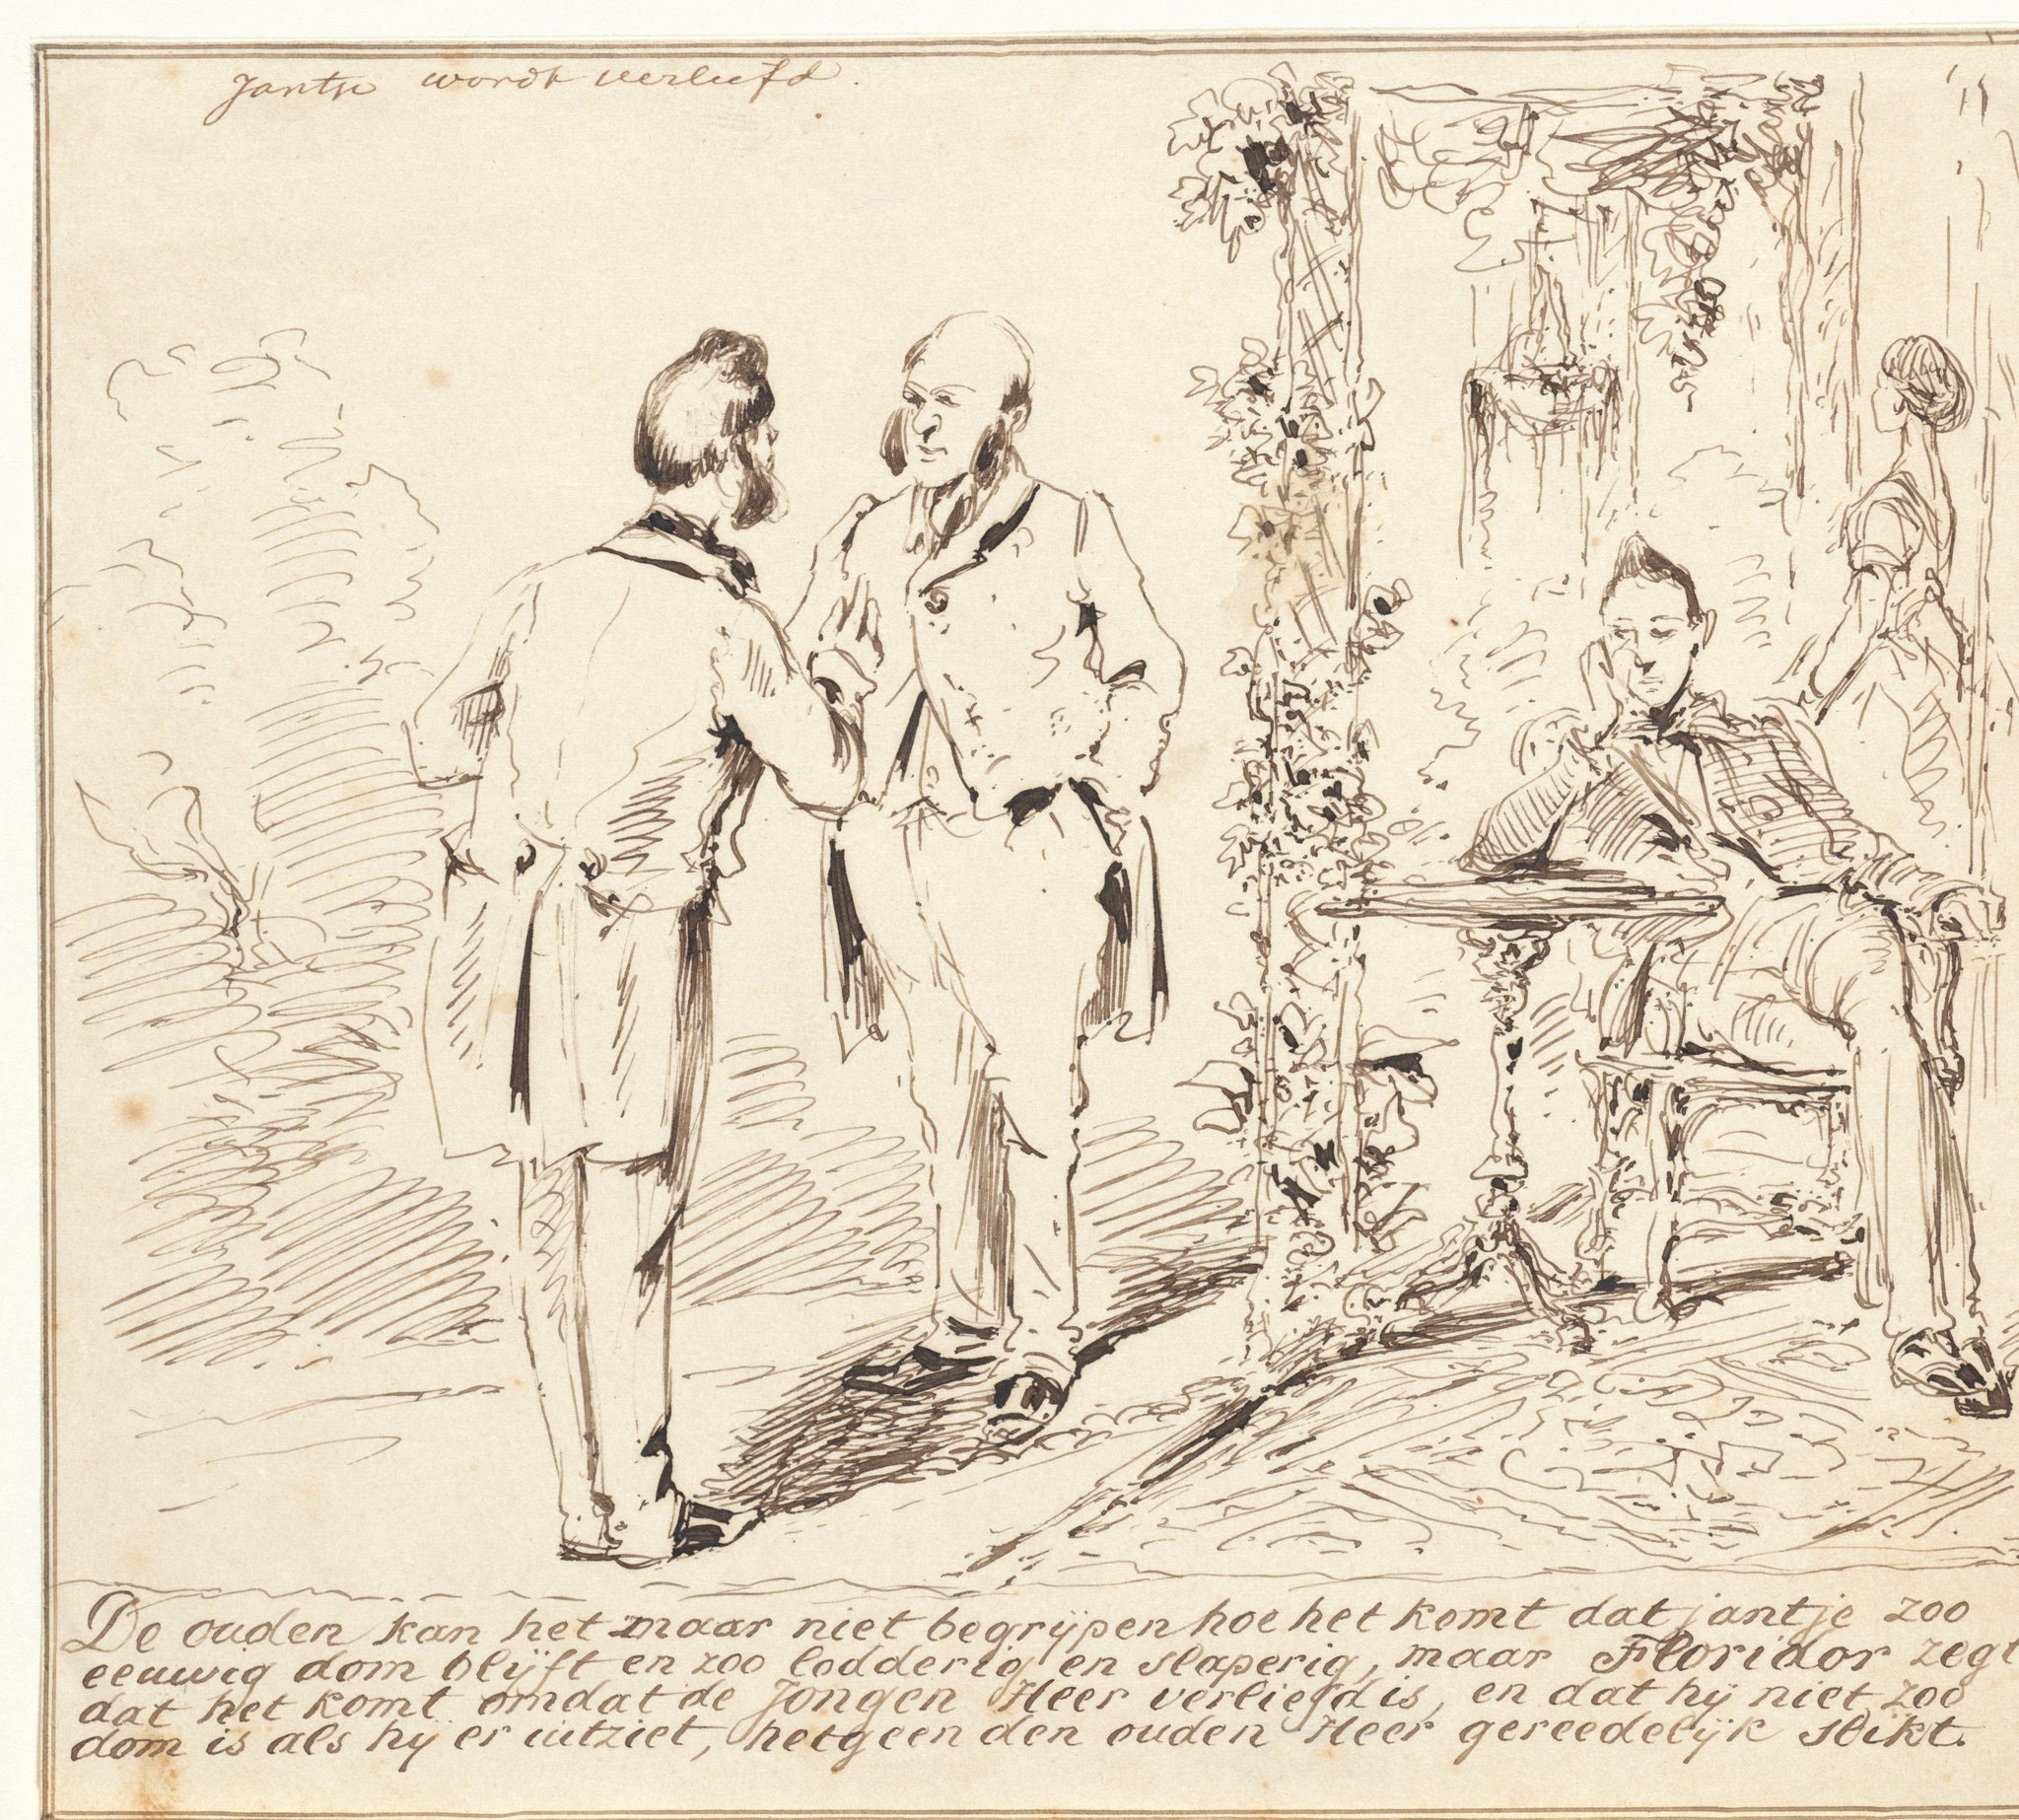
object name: drawing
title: Verhaal van de jongen Jantje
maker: pieter van loon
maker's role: draughtsman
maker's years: 1801-1873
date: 1811-1873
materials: ink, paper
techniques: pen